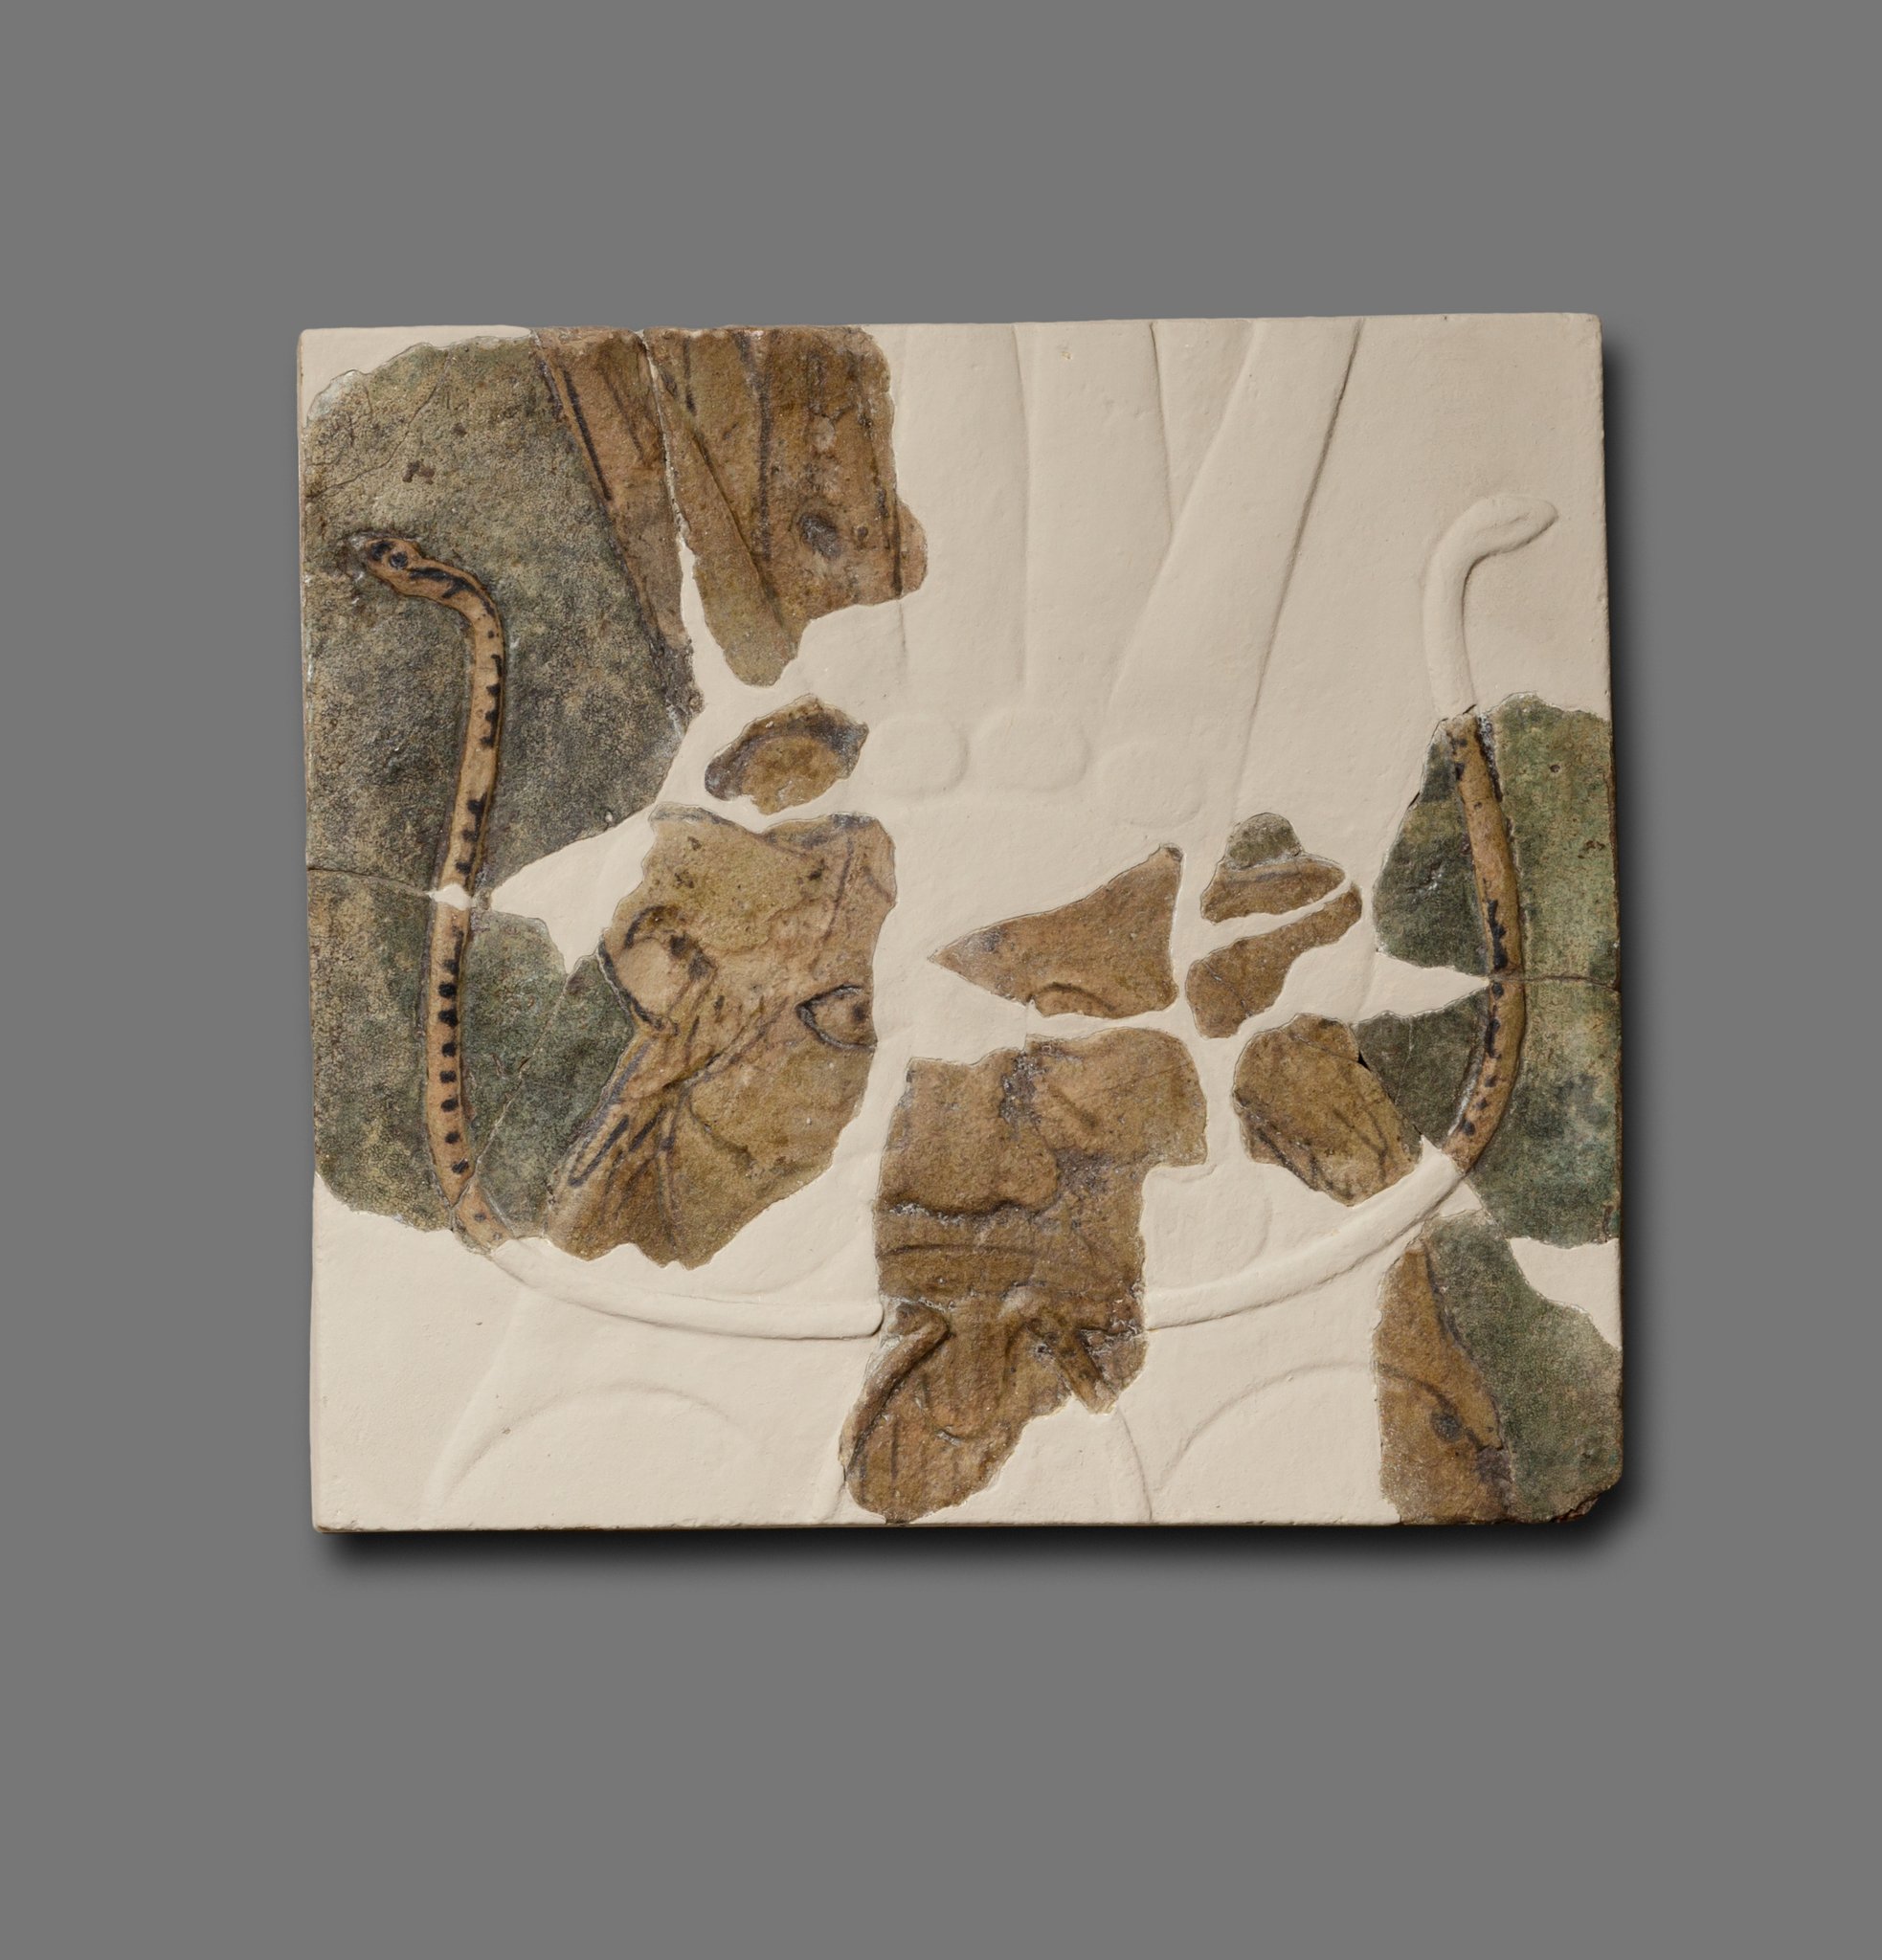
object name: tile inlay, palace of ramesses ii, foreigner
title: Tile with the image of Bes from the palace of Ramesses II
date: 1279-1213 BCE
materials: faience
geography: egypt